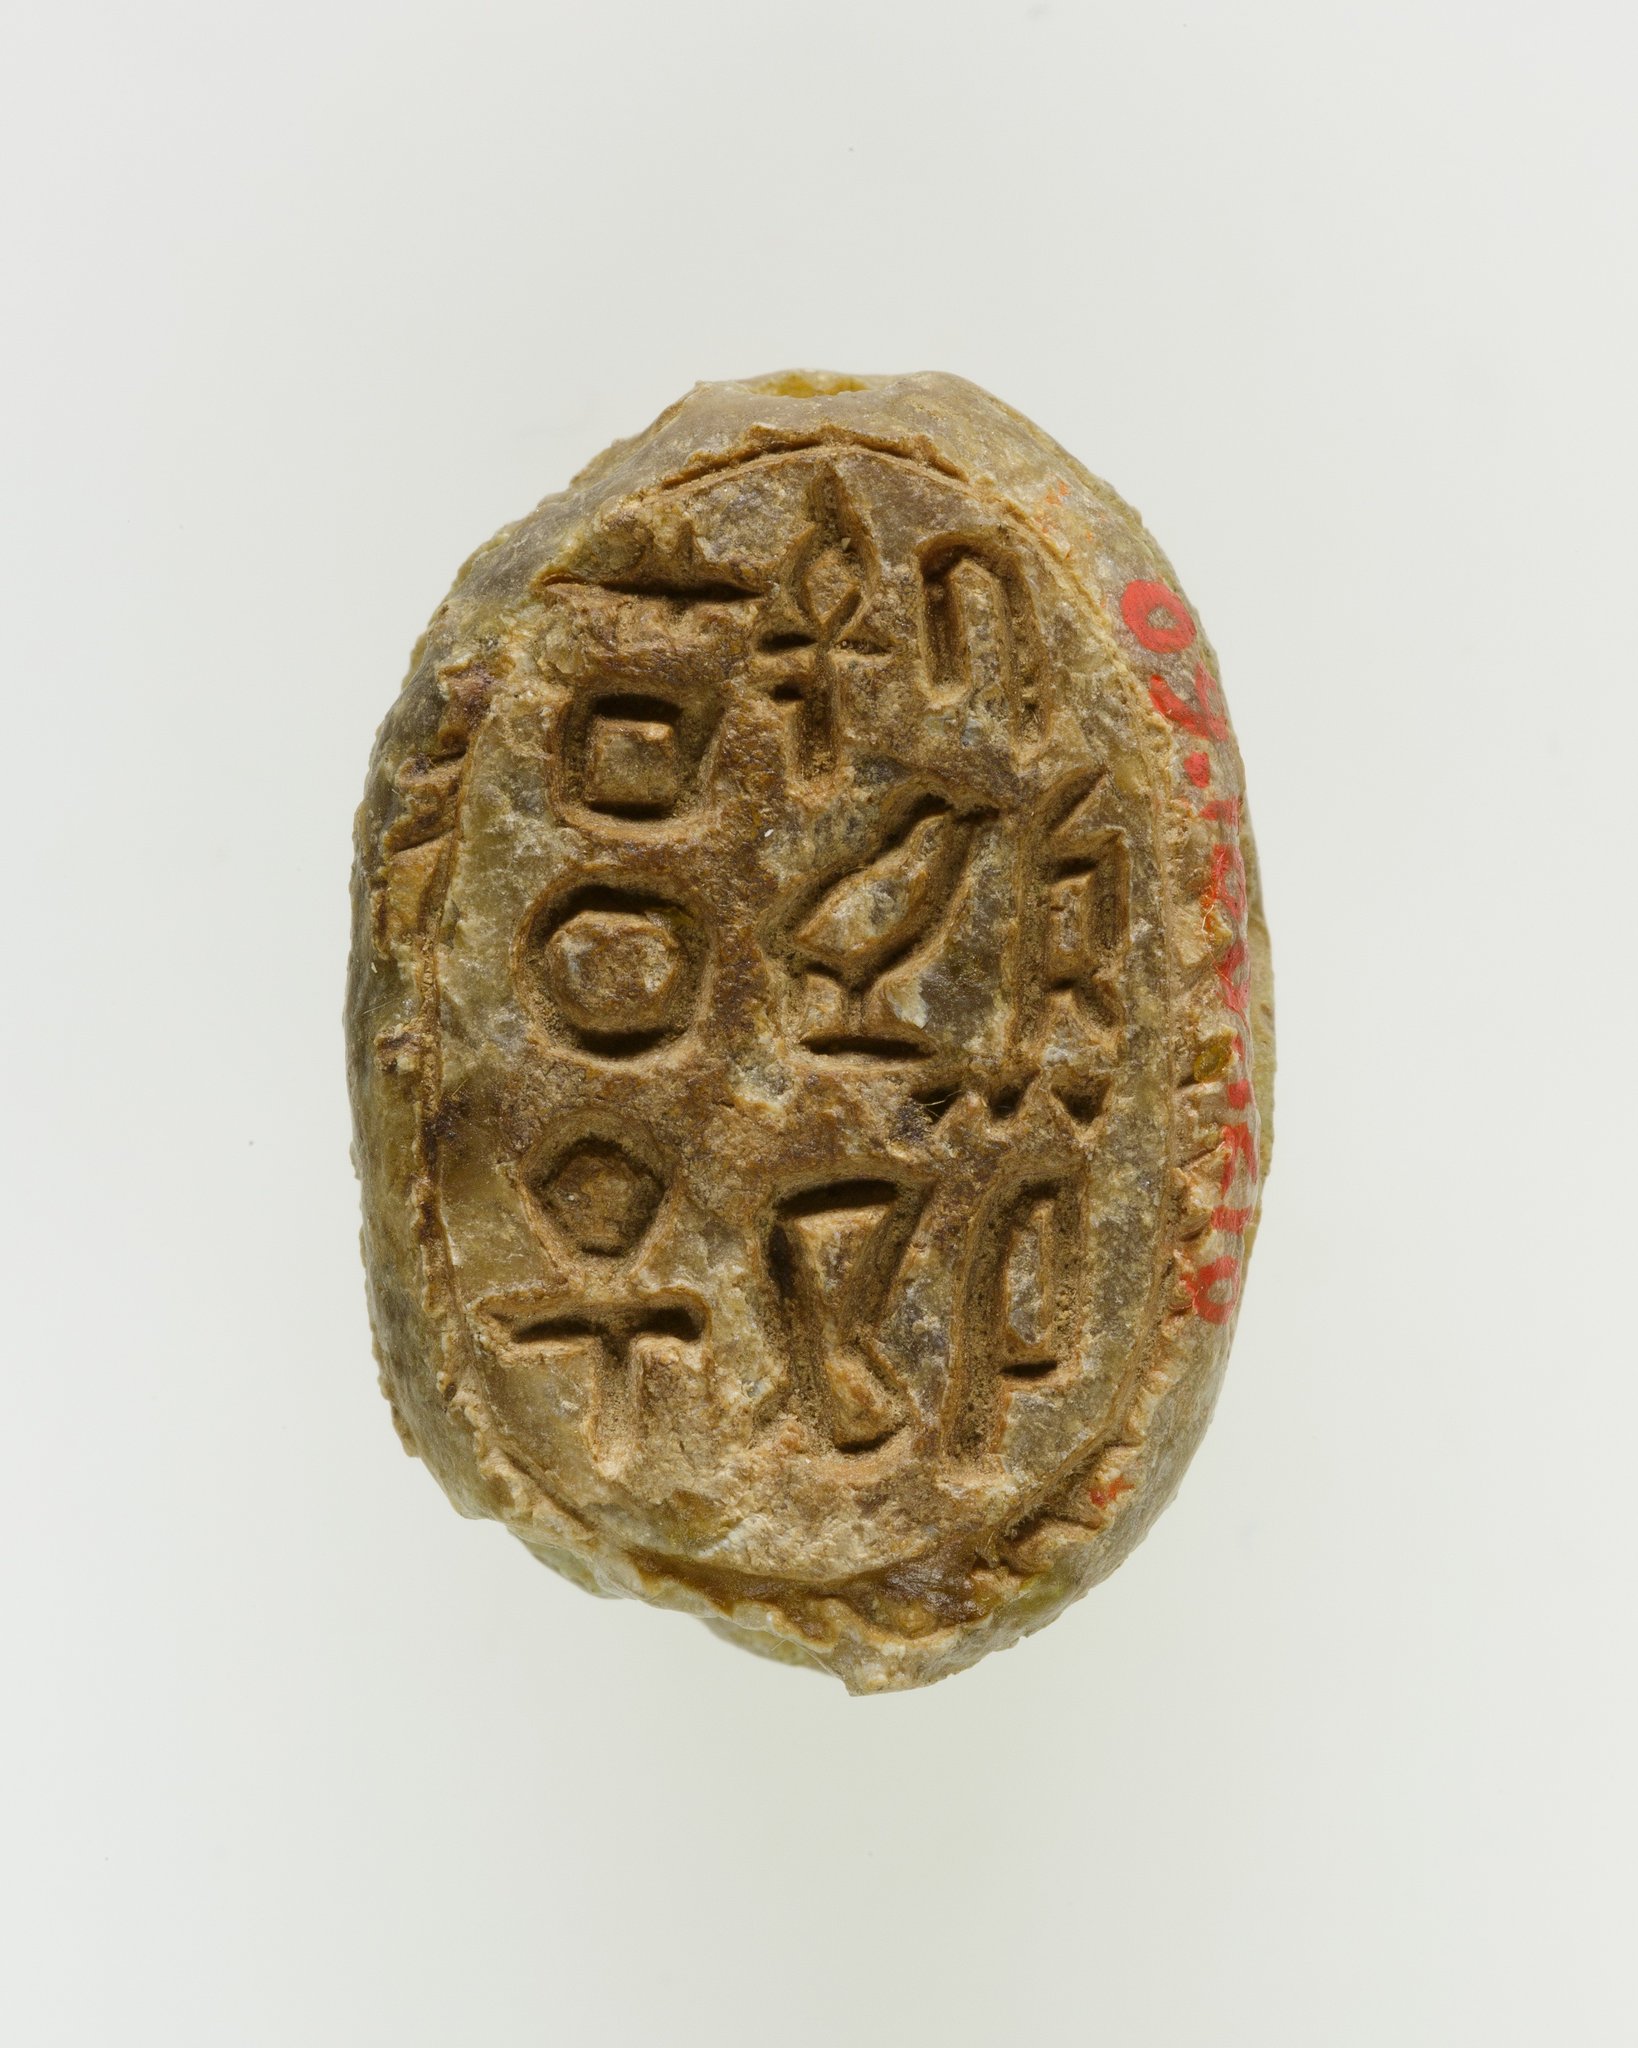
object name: scarab, official, private name and title, funerary epithet, sepi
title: Scarab of an Official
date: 1760-1670 BCE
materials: stone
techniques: glazing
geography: egypt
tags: hieroglyphs,scarabs